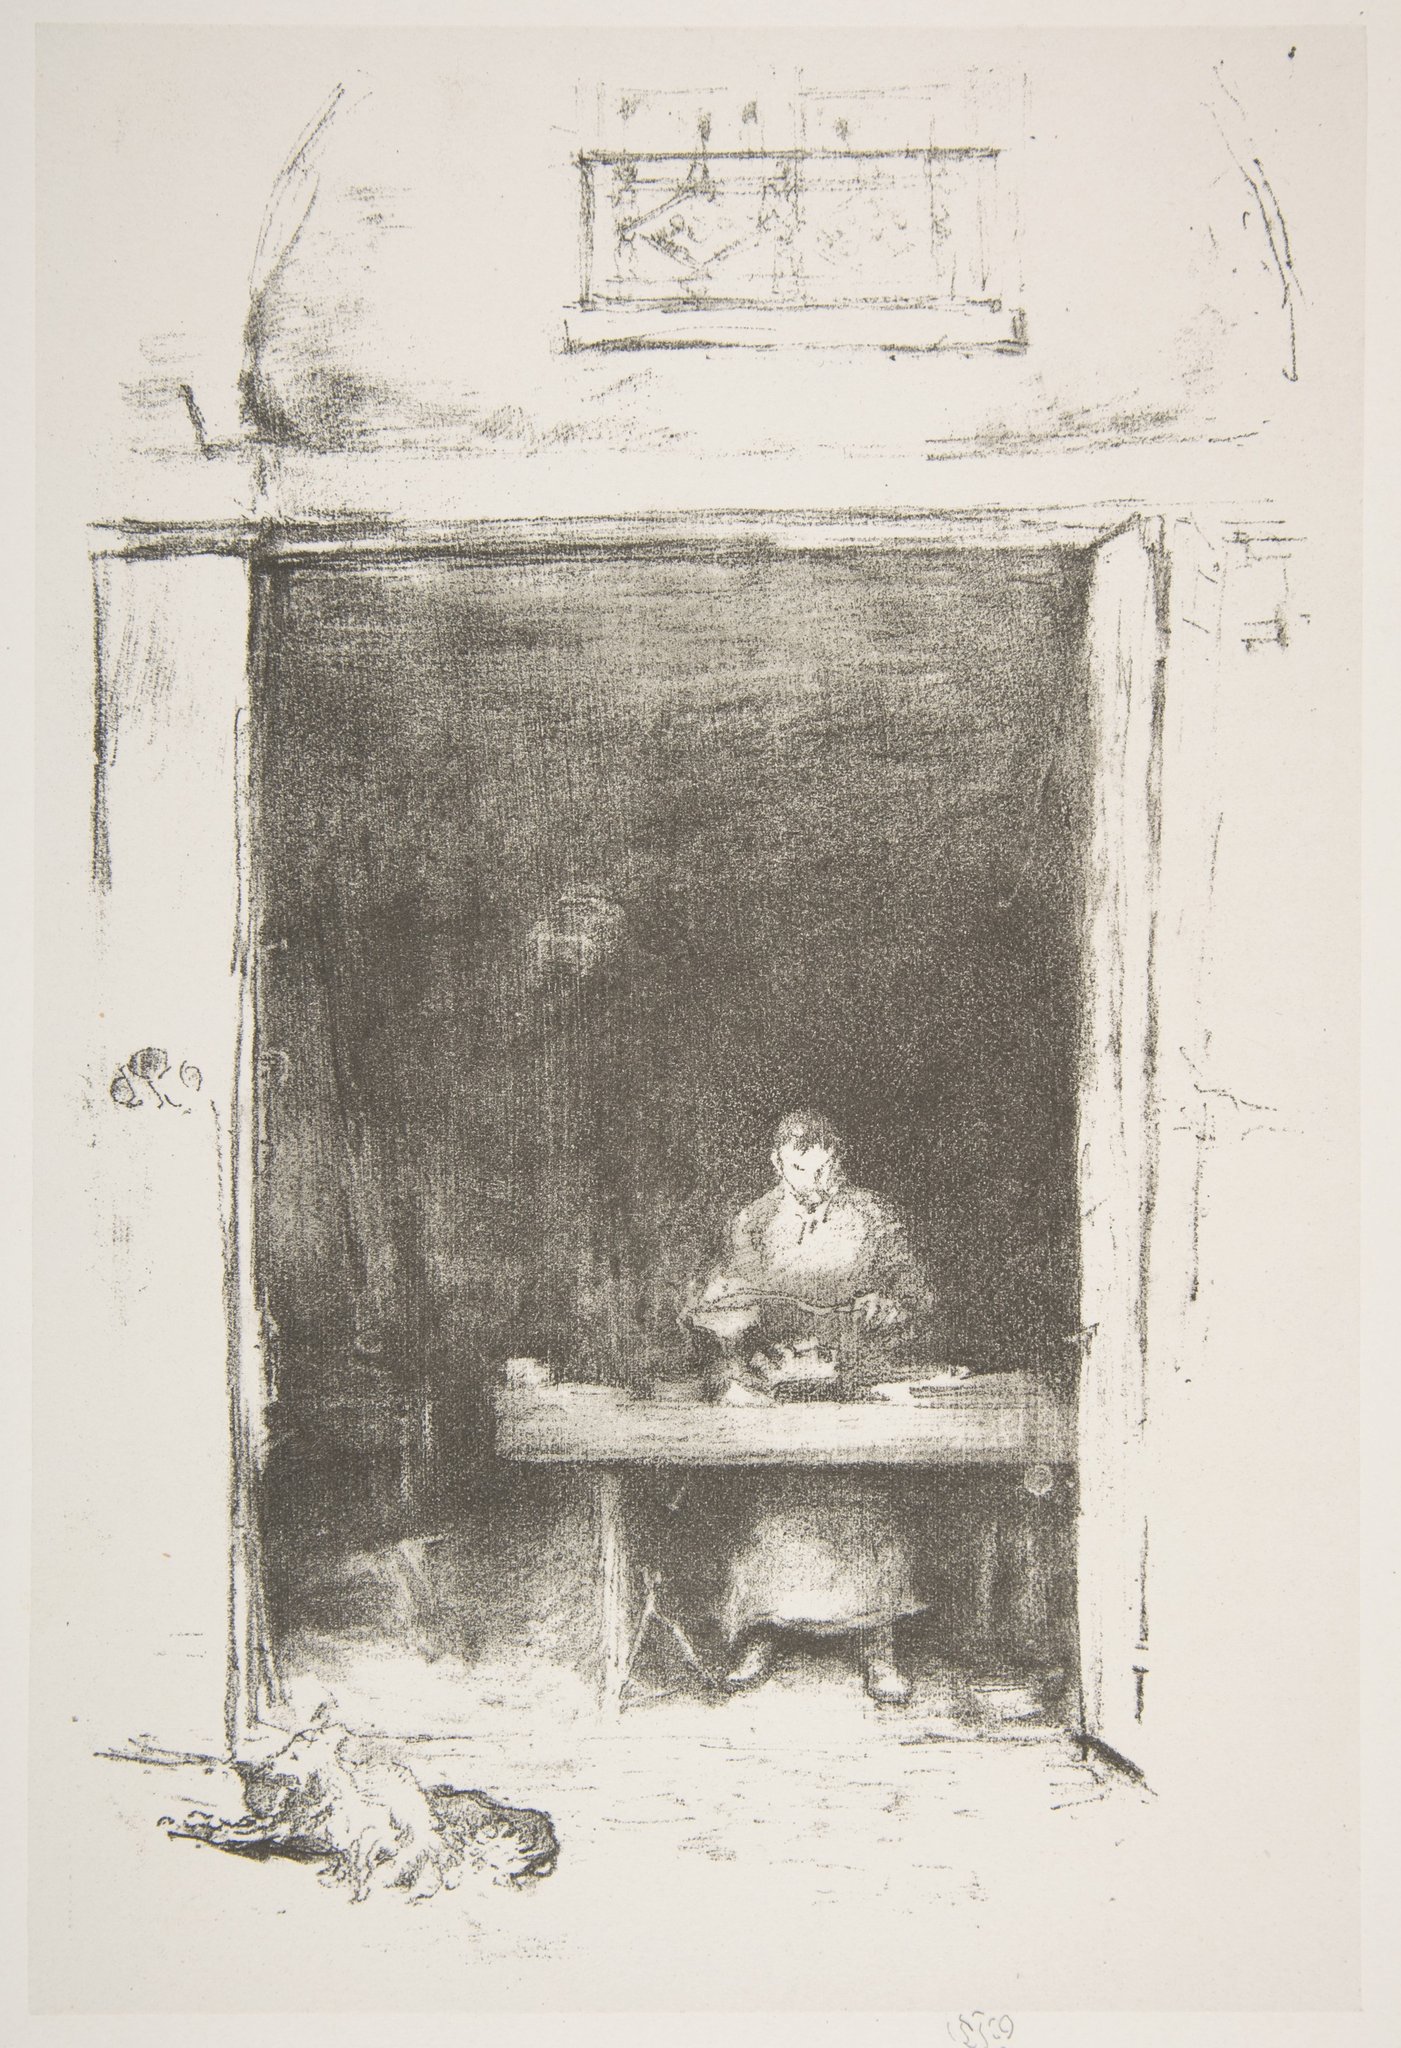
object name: print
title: The Smith, Passage du Dragon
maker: james mcneill whistler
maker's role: artist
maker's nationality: american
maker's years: 1834-1903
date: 1894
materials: chine, ivory, paper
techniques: printing, stumping, lithography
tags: men,working